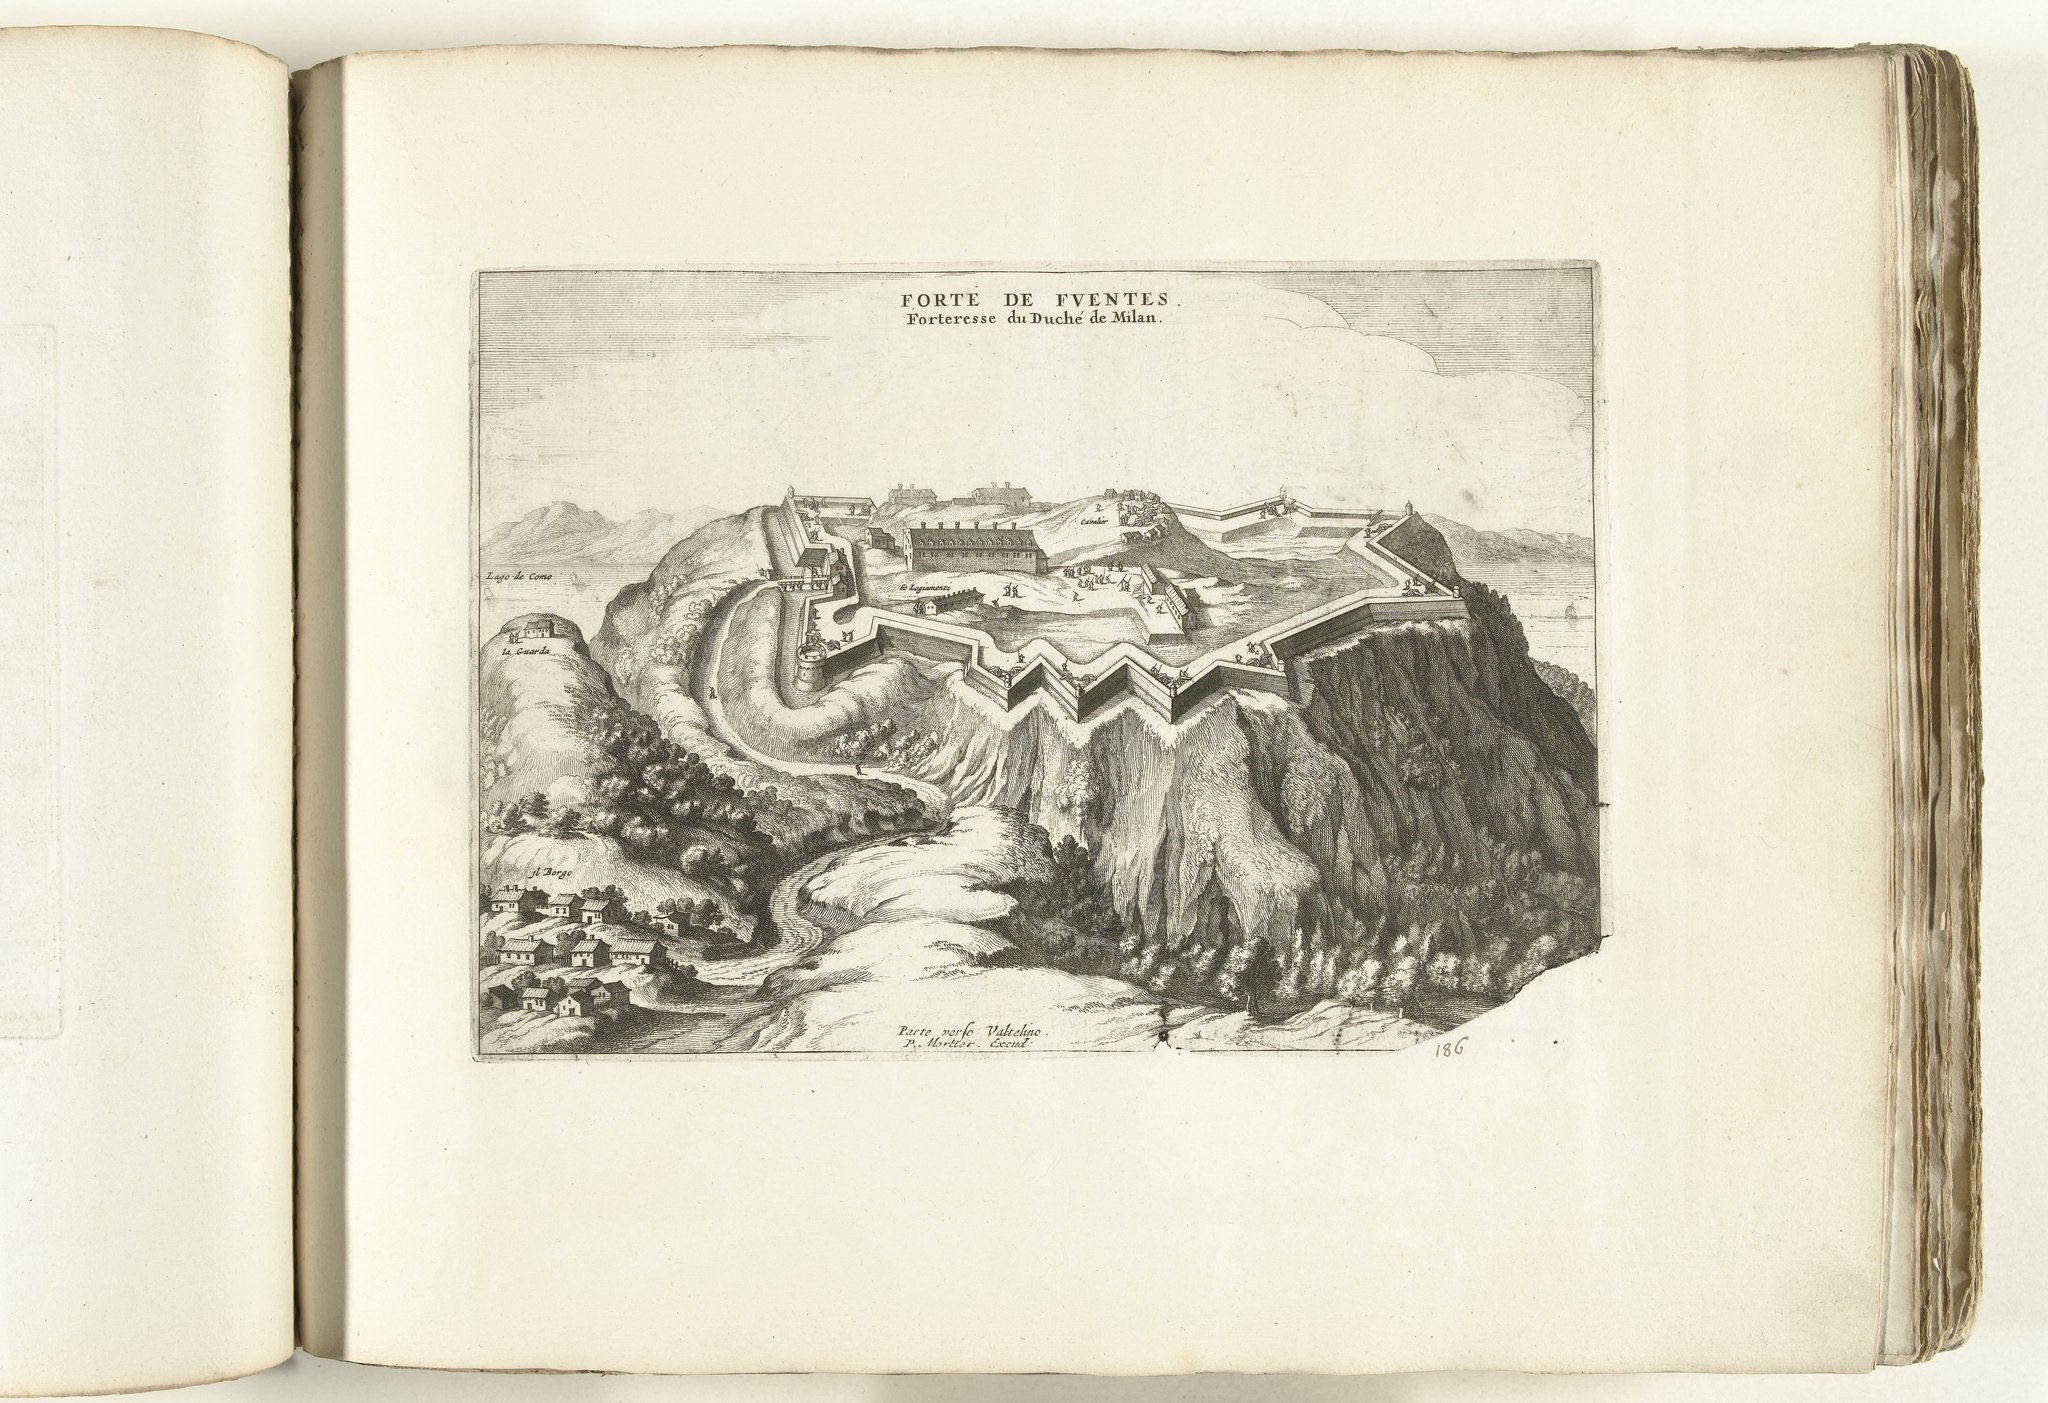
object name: map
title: Les Forces de l'Europe, Asie, Afrique et Amerique, ou description des principales villes avec leurs fortifications. Dessignées par les meilleurs ingenieurs, particulierement celles qui sont sous la domination de la France (...) et ornées de plusieurs superbes edifices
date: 1702-1703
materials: paper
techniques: etching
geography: amsterdam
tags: fortress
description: Gezicht op het door de Spanjaarden gebouwde vesting Forte de Fuentes, bij Colico aan het Como meer. Plaat nr. 186 in het prentwerk bestaande in totaal uit 276 genummerde platen van vermaarde sterke steden en vestingen in het kader van de Spaanse Successieoorlog. Voor het merendeel zijn deze platen gekopieerd naar de anonieme Franse platen: in Les forces de l'Europe en in: Le theatre de la guerre, dans les Pays-Bas, beide oorspronkelijk uitgegeven door Nicolas de Fer te Parijs (1693-1697) in het kader van de Negenjarige Oorlog. Titel en opschriften in de plaat in het Frans.